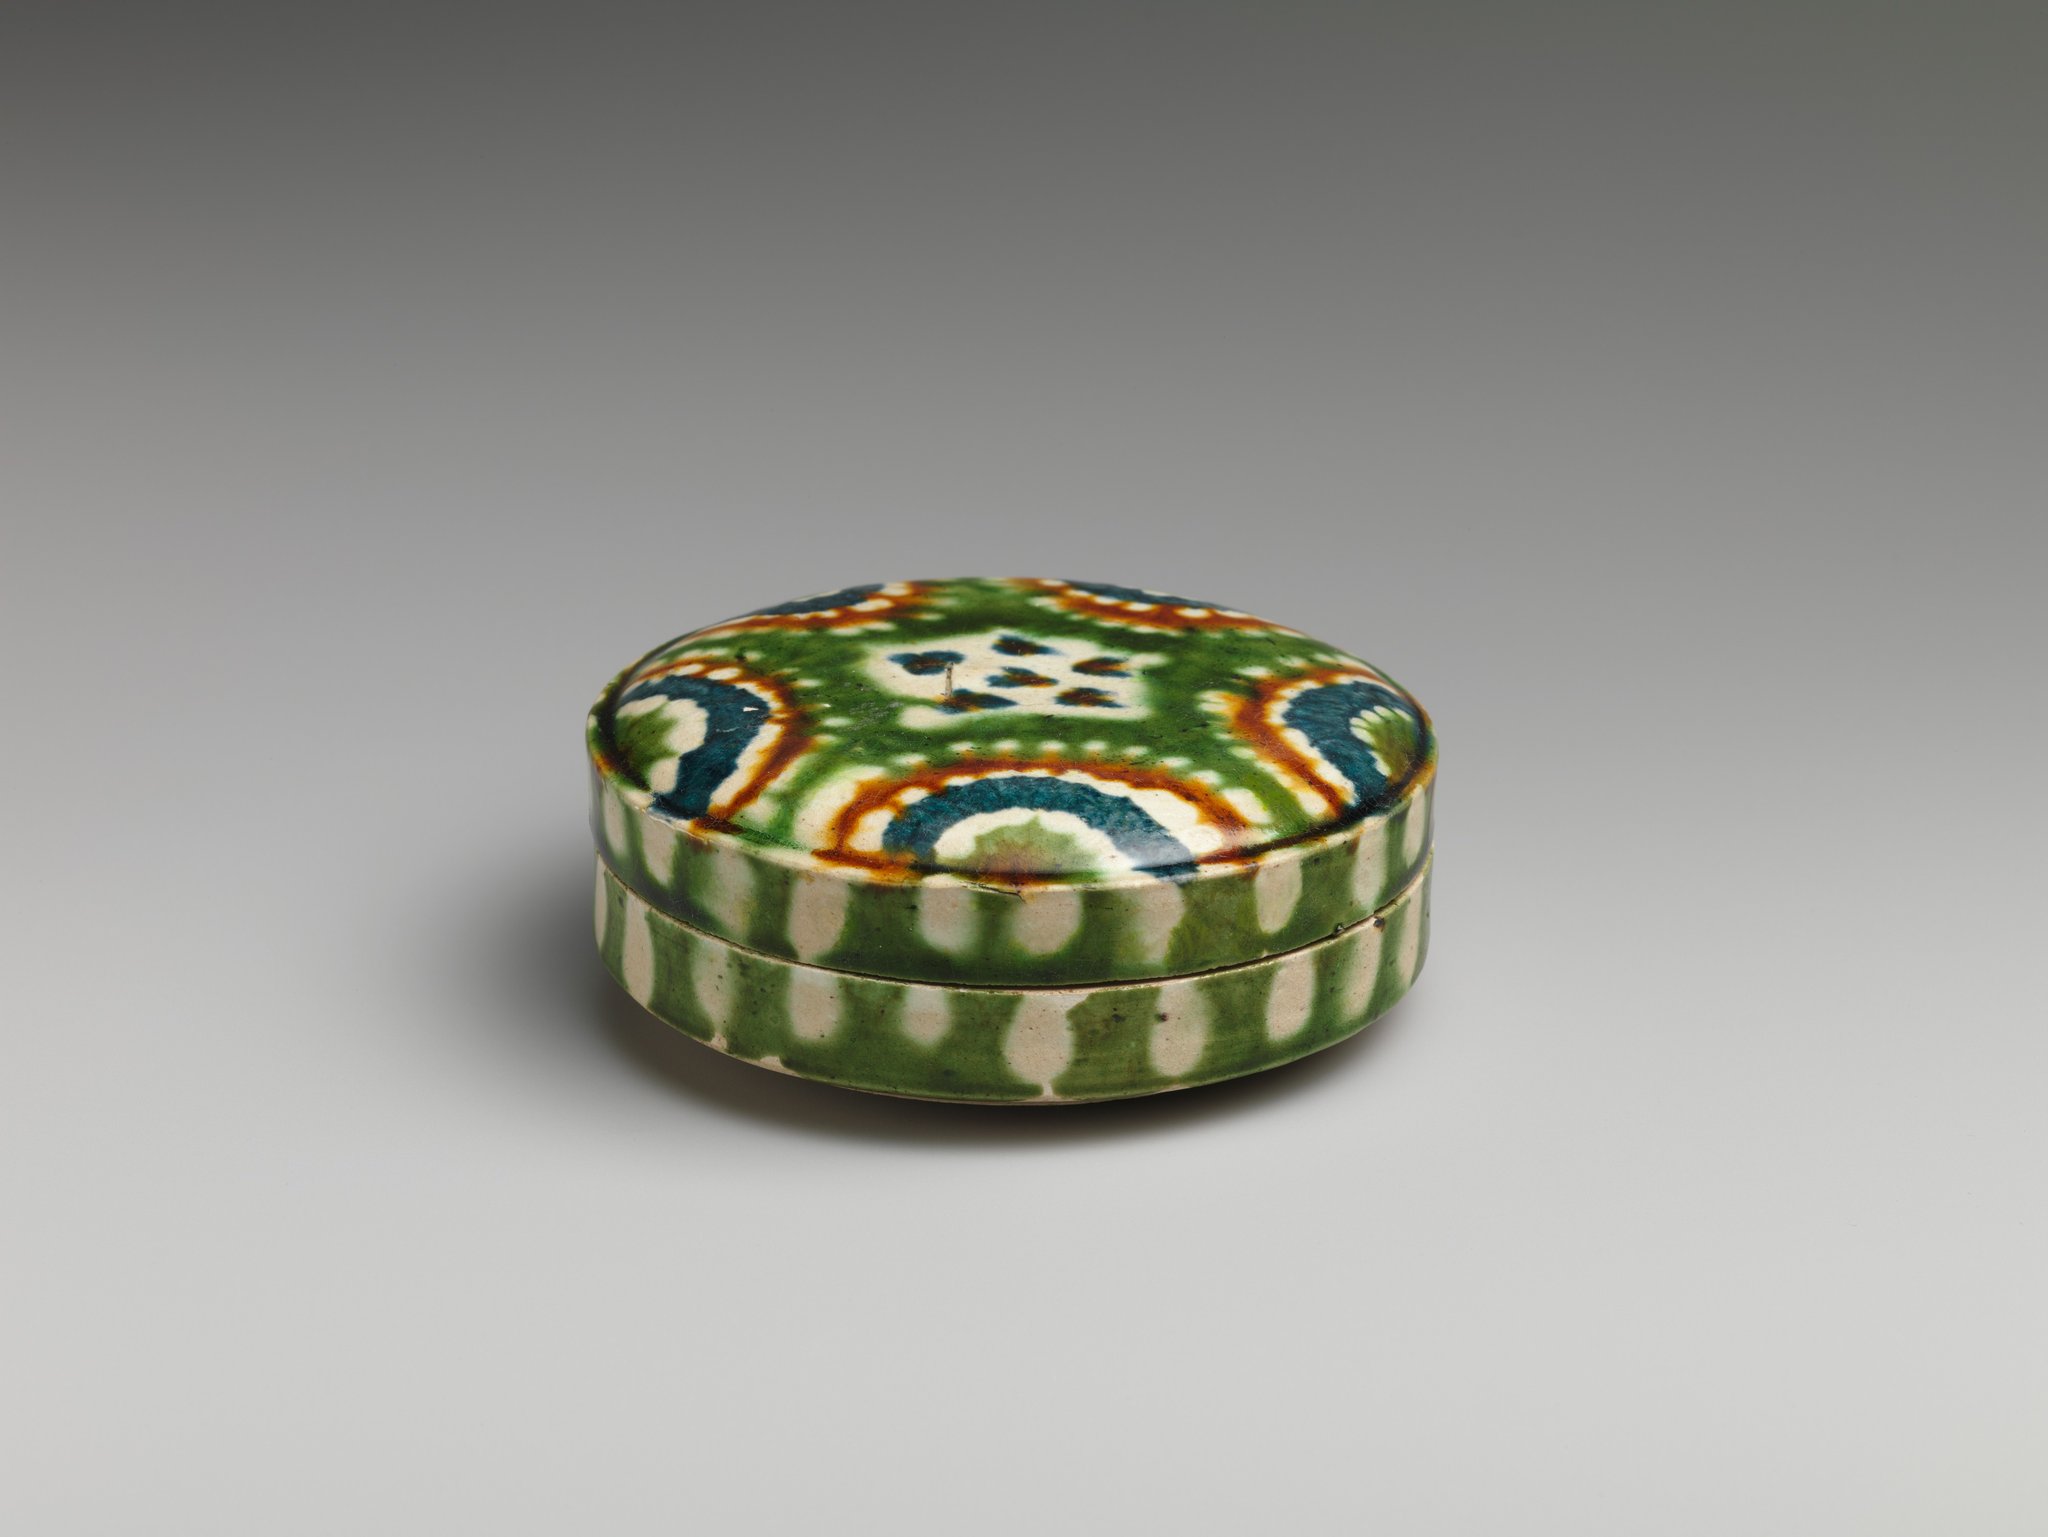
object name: covered box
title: Box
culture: chinese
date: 701-733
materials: earthenware, glaze